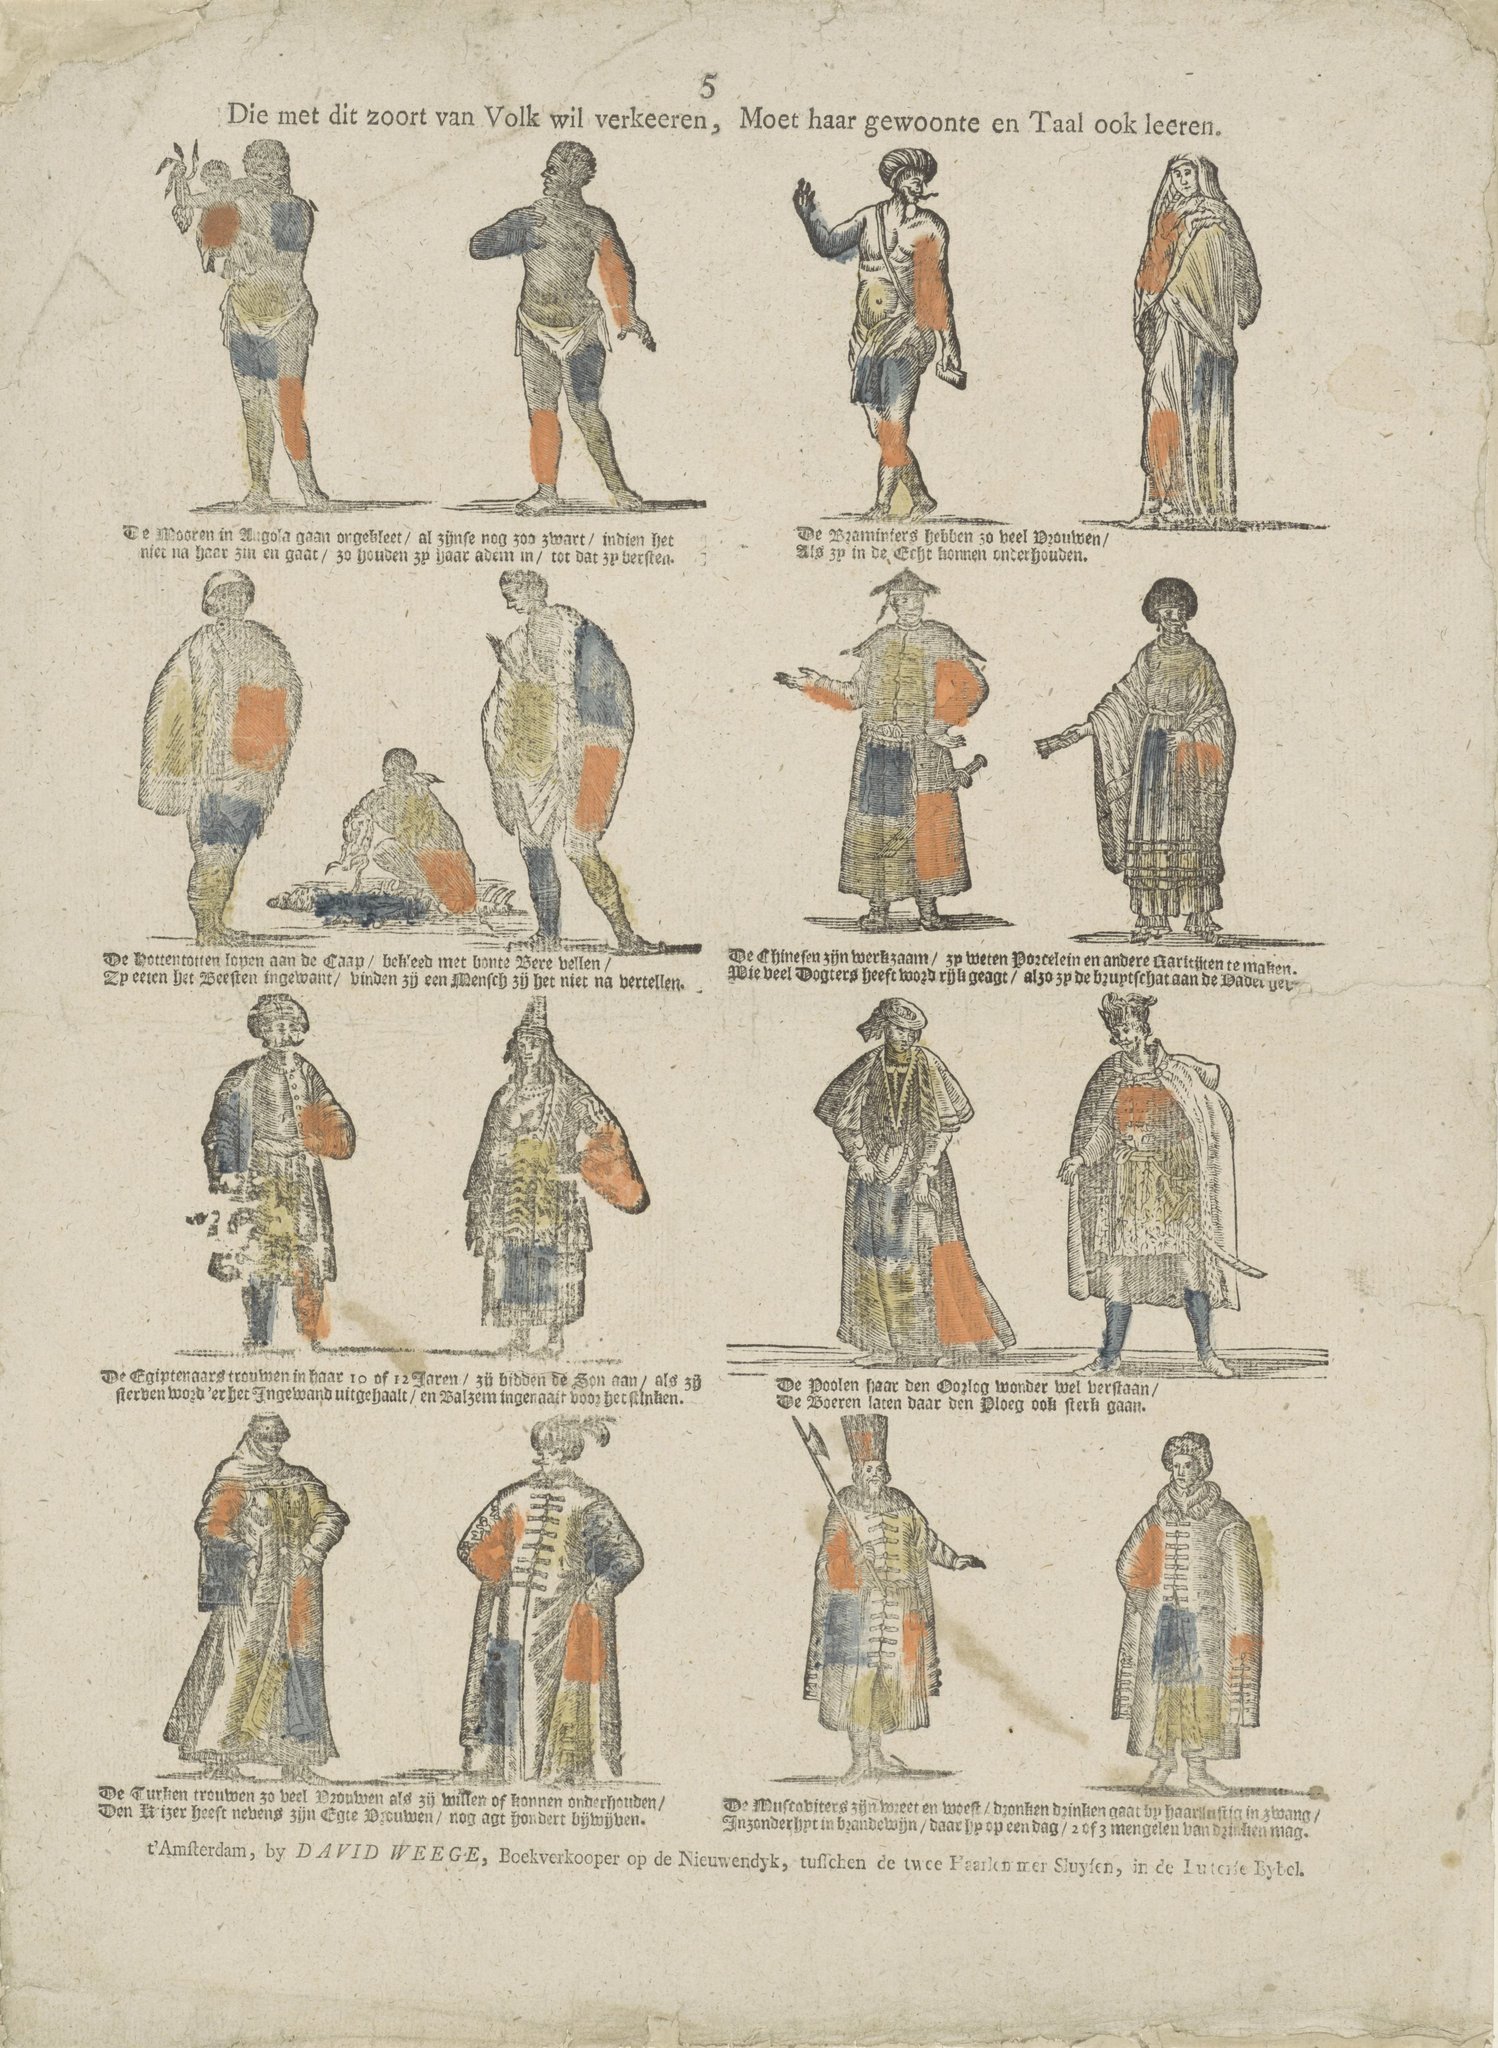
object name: popular print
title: Die met dit zoort van volk wil verkeeren, / Moet haar gewoonte en taal ook leeren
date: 1748-1787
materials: paper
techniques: colour, letterpress printing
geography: amsterdam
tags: asiatic races and peoples, asiatic races and peoples: turks, chinese, africans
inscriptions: collector's mark: Lugt 2760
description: Blad met 12 voorstellingen van mensen van verschillende volken, waaronder Moren, Khoikhoi, Polen en Turken. Onder elke afbeelding een onderschrift. Genummerd midden boven: No. 5.